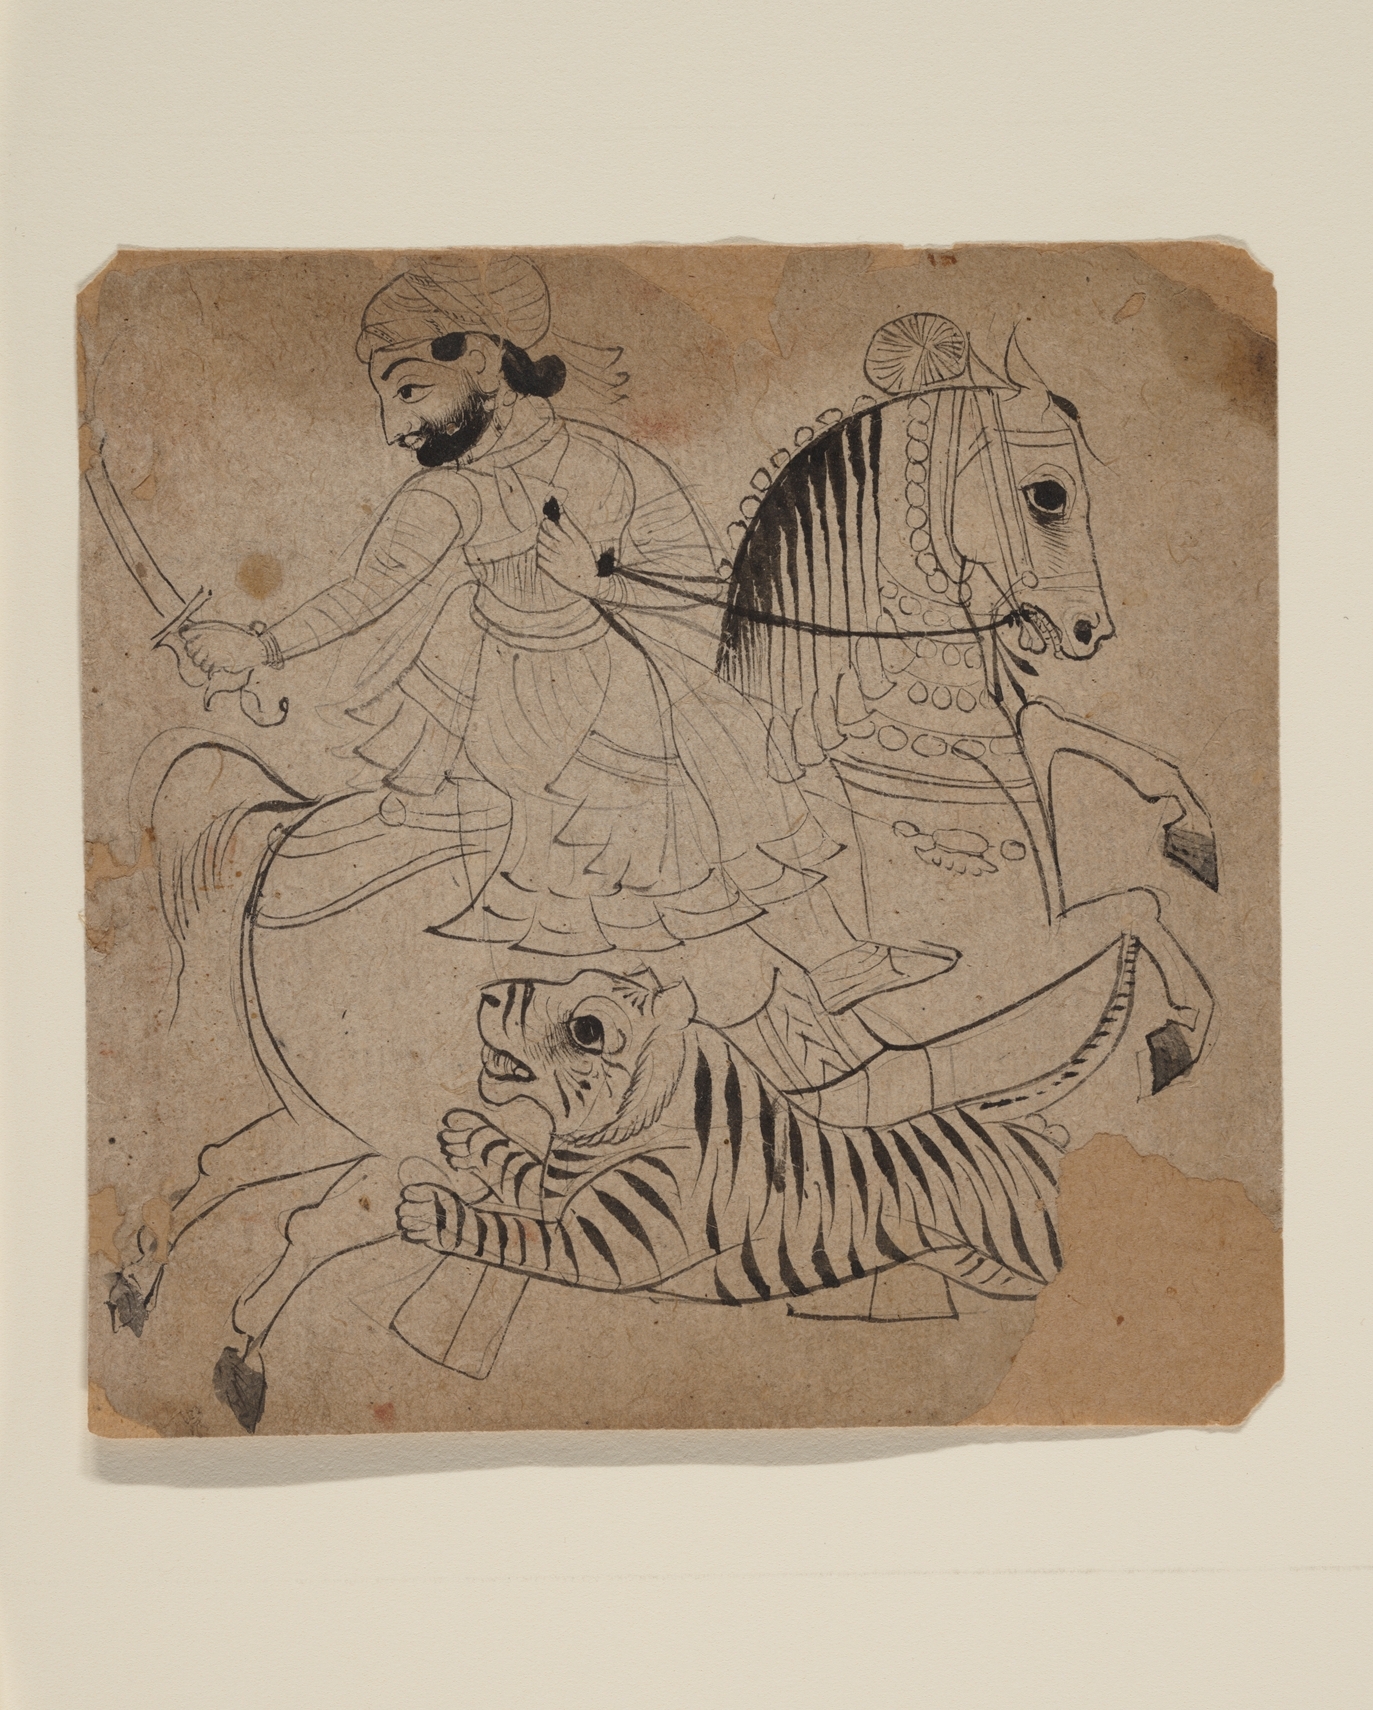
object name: painting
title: Nobleman Hunting a Tiger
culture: western indian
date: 1830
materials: ink, paper, watercolor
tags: men,hunting,horses,tigers